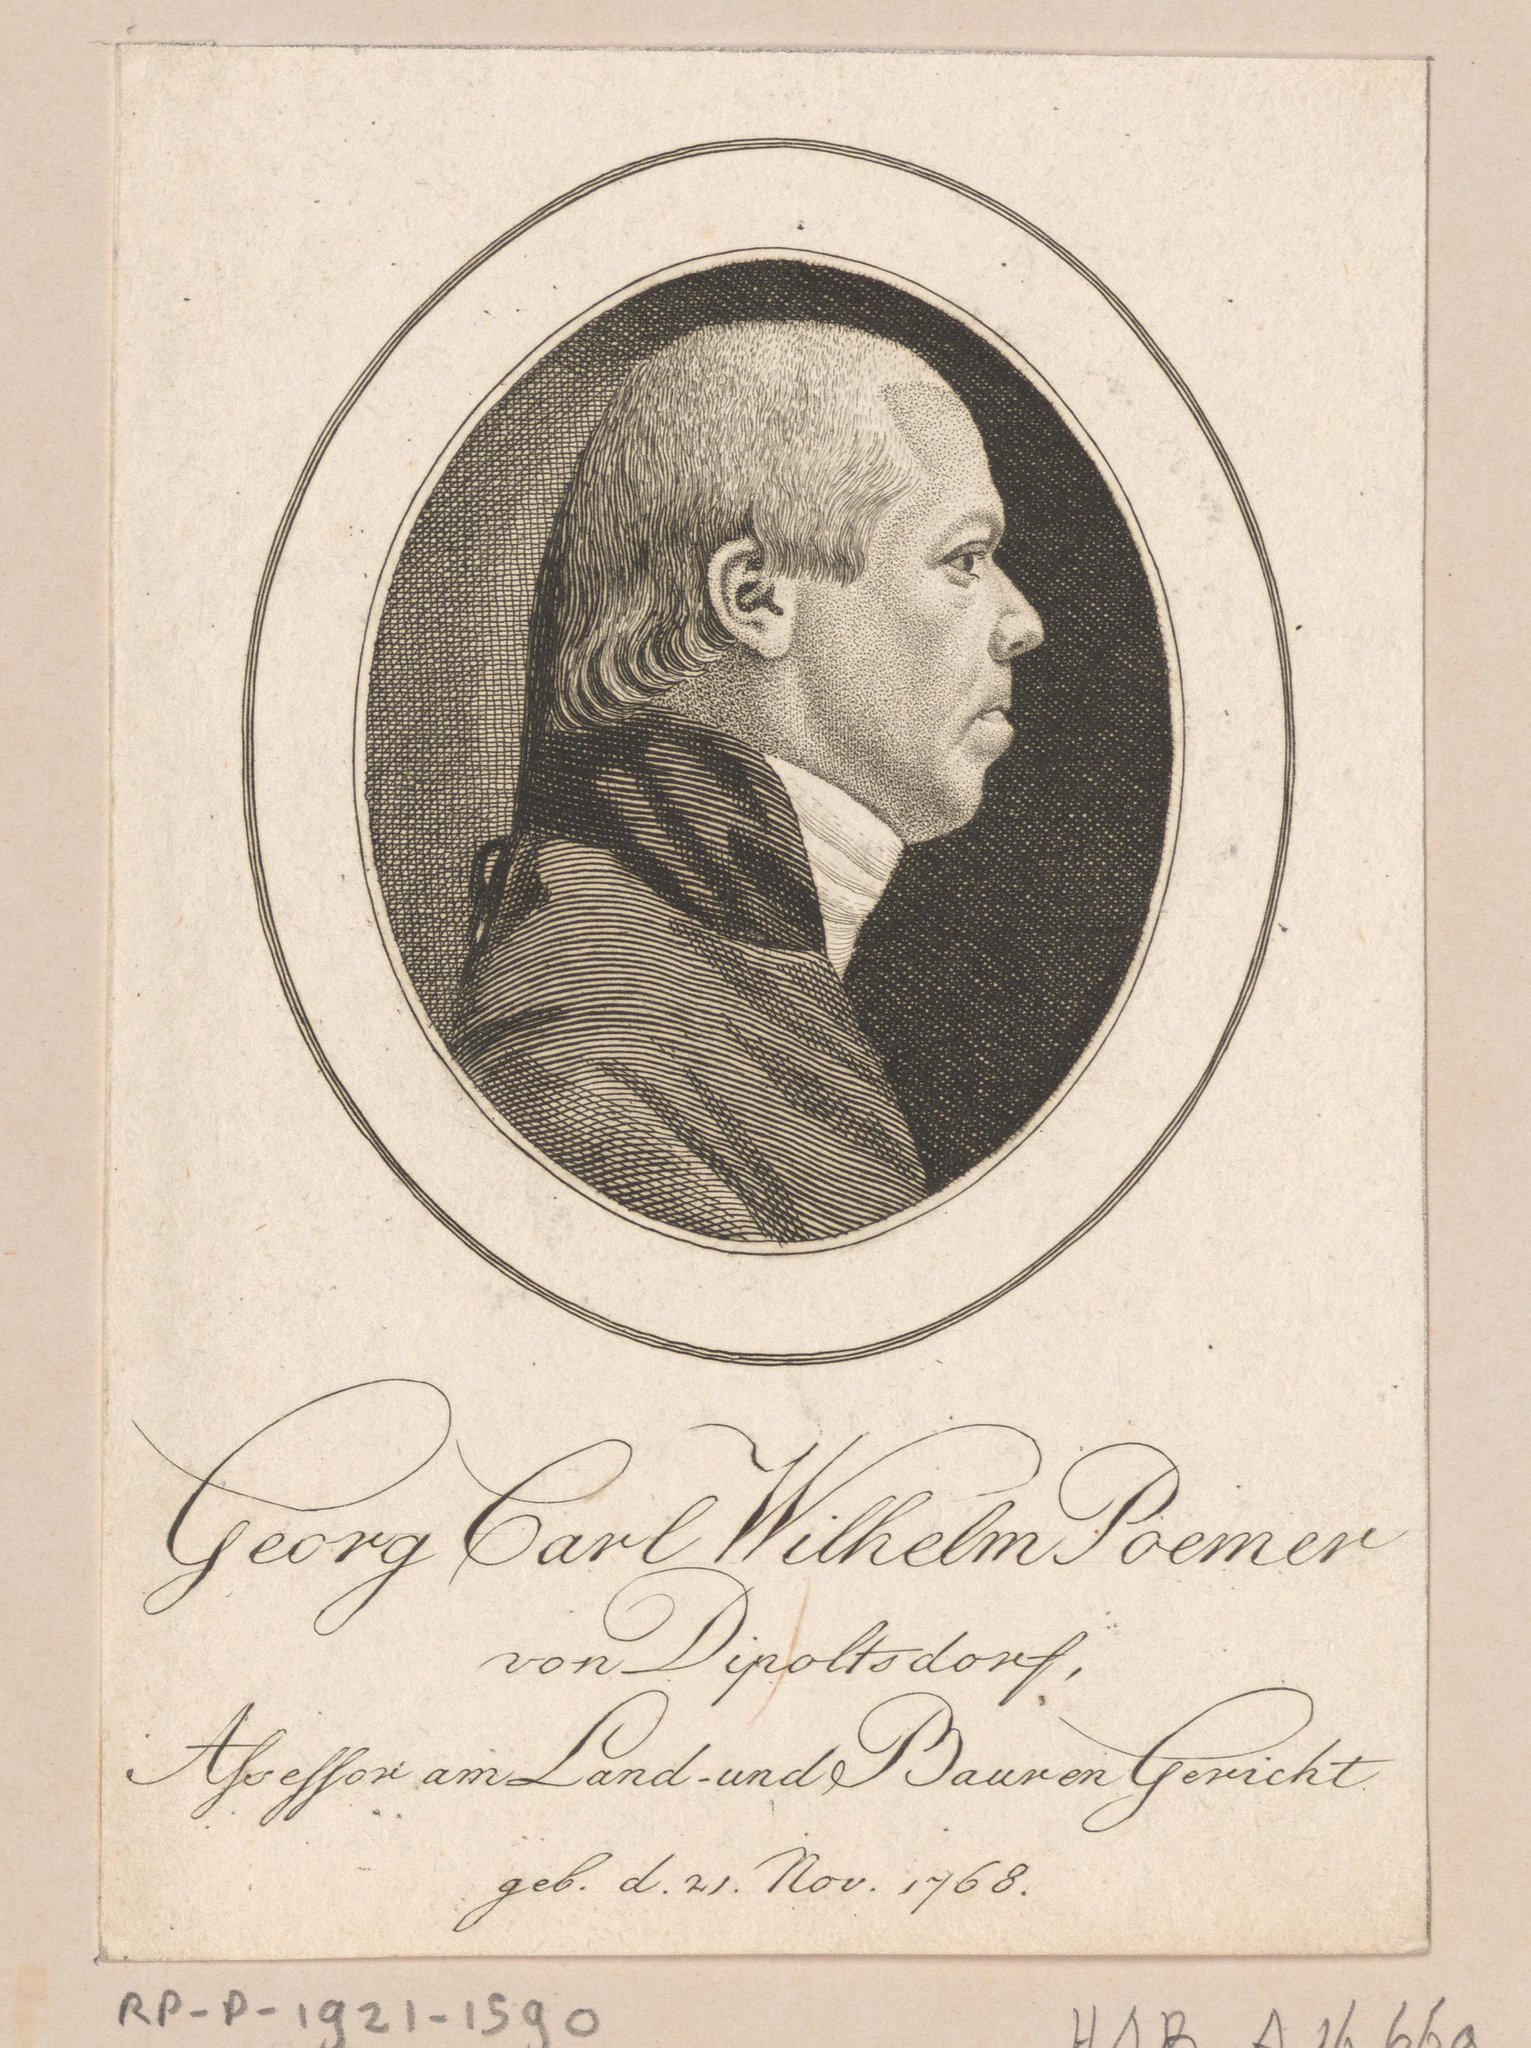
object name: print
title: Portret van Georg Carl Wilhelm Pömer von Diepoltsdorf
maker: christoph wilhelm bock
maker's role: print maker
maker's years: 1755-1836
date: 1804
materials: paper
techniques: engraving, etching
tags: historical persons, law and jurisprudence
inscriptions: collector's mark: Lugt 2233